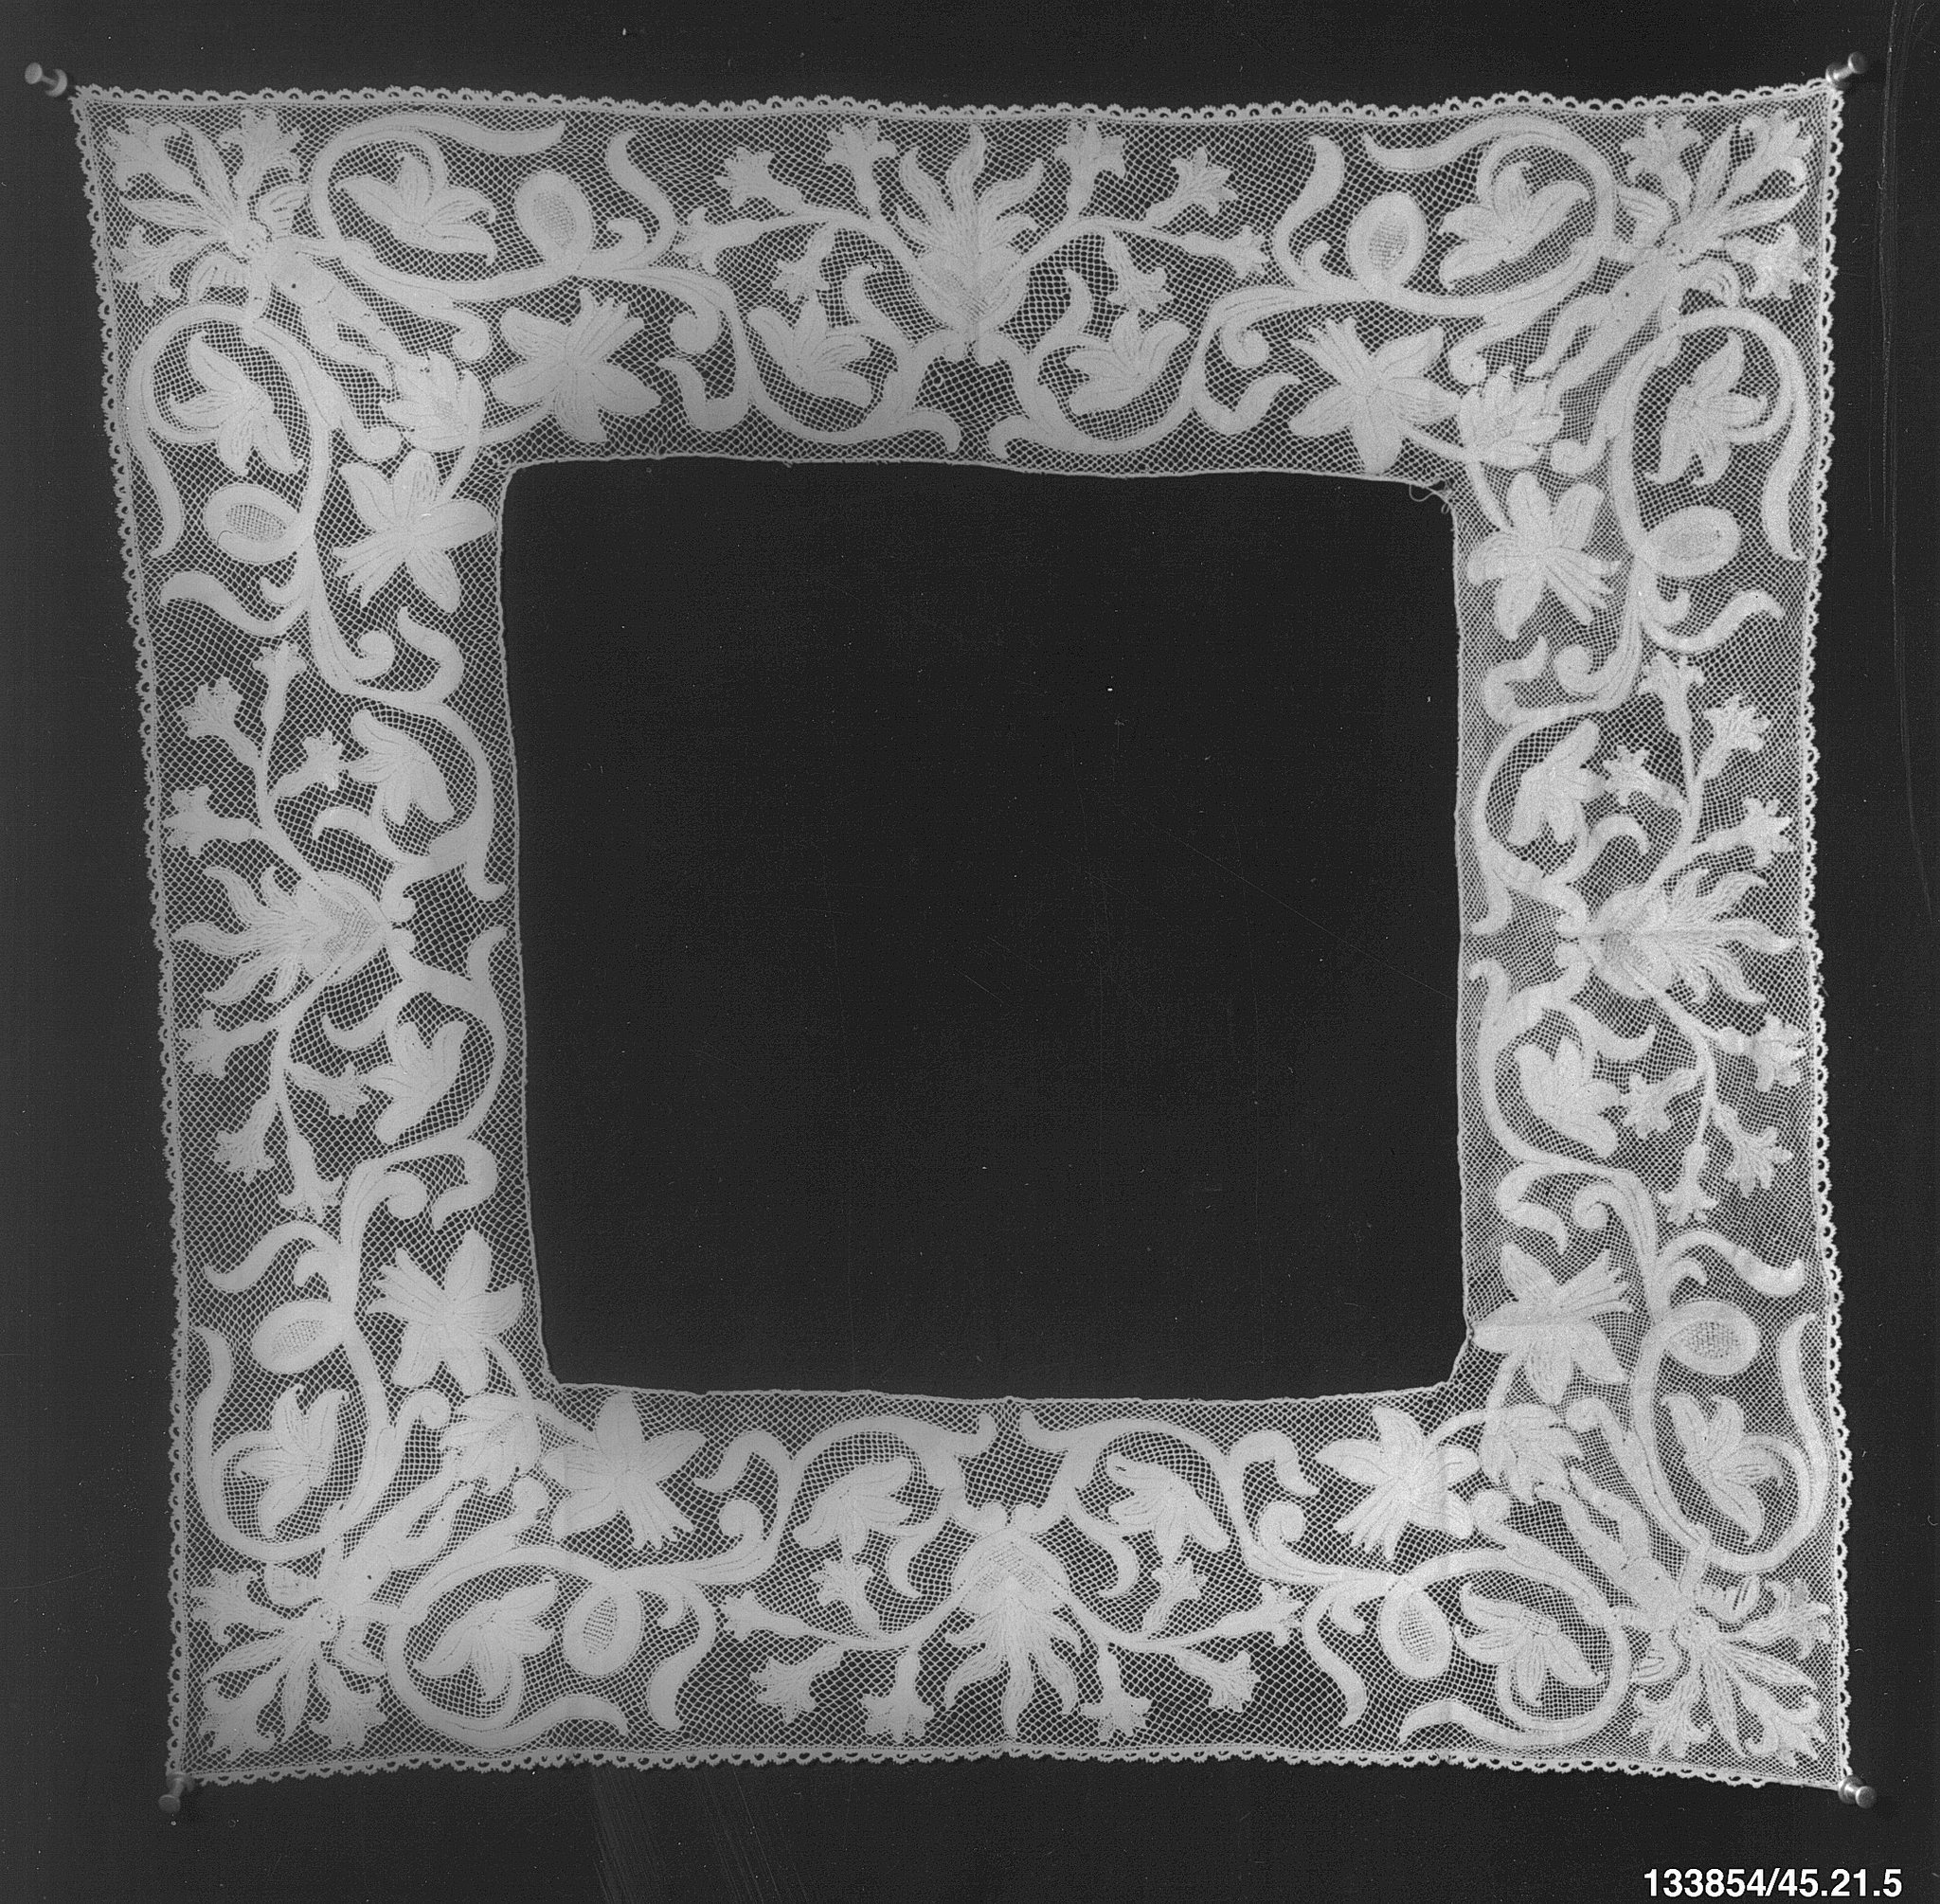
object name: border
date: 1701-1733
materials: lace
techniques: lace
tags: flowers